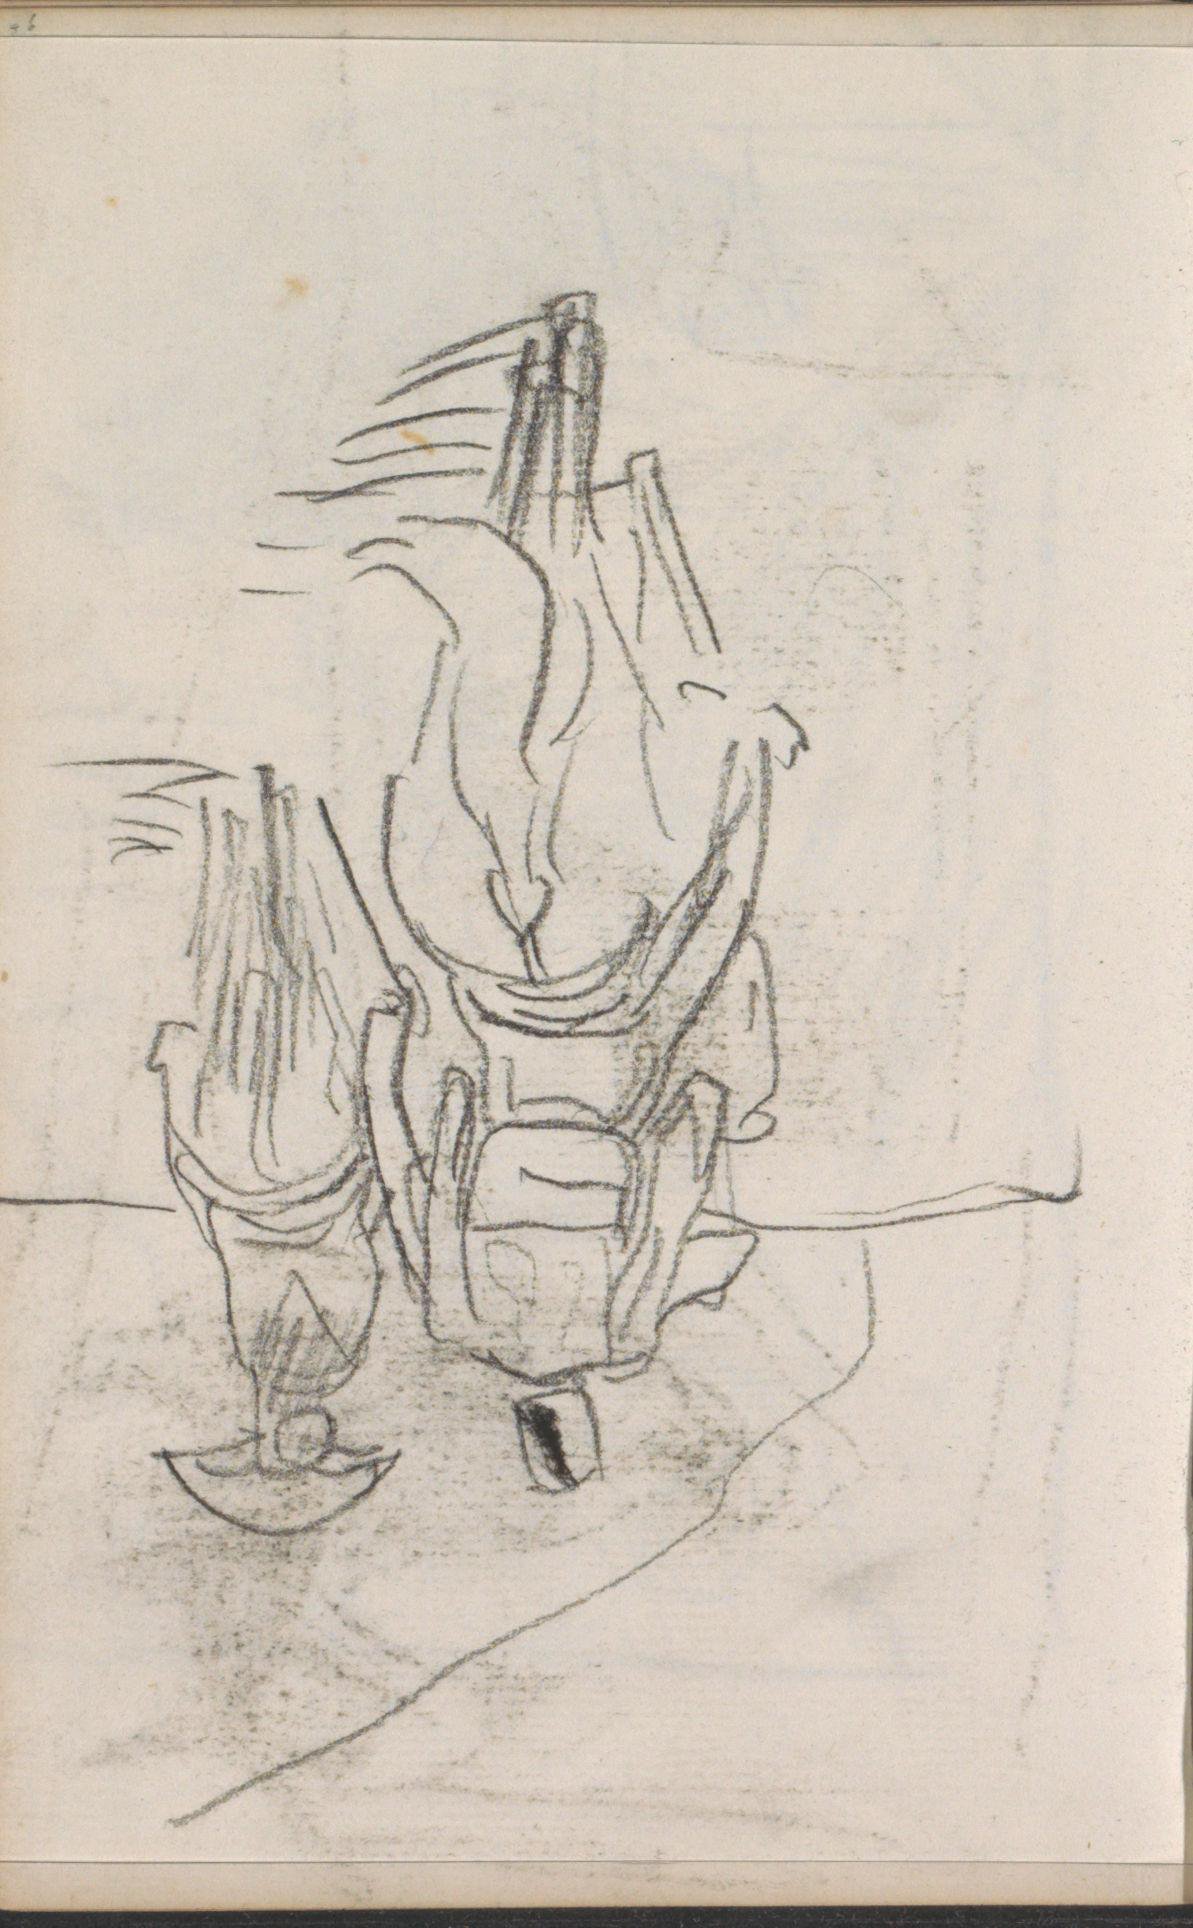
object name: sketchbook leaf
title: Twee ruiters in oosterse kleding, op de rug gezien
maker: marius bauer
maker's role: draughtsman, print maker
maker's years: 1867-1932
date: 1899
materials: chalk, paper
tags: riding a horse, ass, or mule; rider, horseman, clothes, costume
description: Pagina 36 uit een schetsboek met 42 bladen.